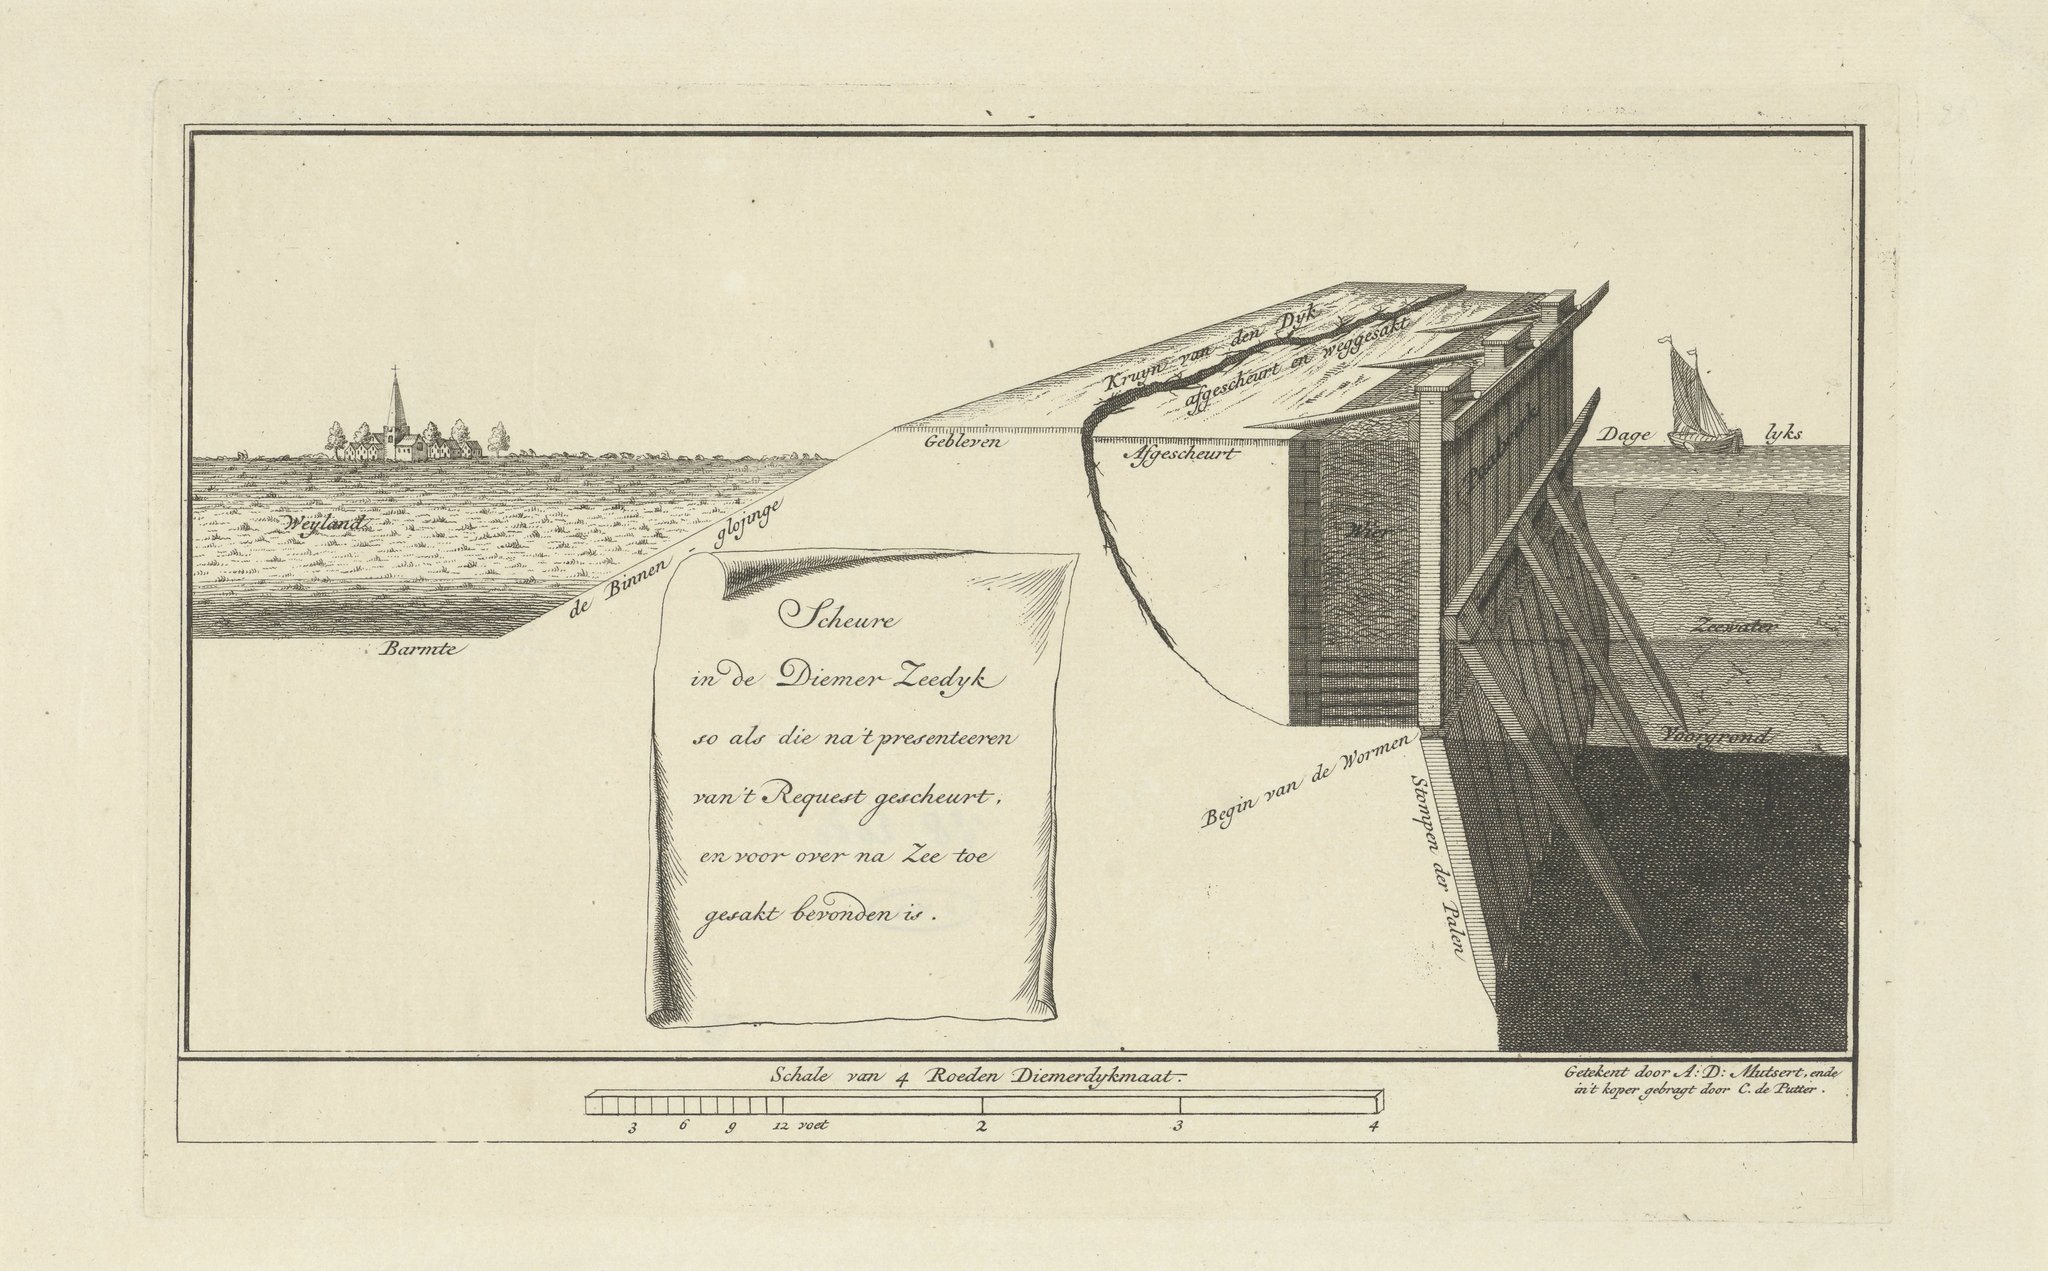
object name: print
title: Profiel van de Diemerzeedijk met scheur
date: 1729-1737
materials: paper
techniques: engraving, etching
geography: amsterdam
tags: dike-break, prospect of village, silhouette of village, sailing-ship, sailing-boat, dikes, levee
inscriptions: collector's mark: Lugt 2228, collector's mark: Lugt 2165, collector's mark: Lugt 2760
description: Rond 1730 waren de houten palen van de Diemerzeedijk ernstig aangetast door paalworm. In 1737 zouden de houten palen worden vervangen door stenen. Landmeter A.D. Mutsert maakte een aantal tekeningen van de toenmalige Diemerzeedijk en Diemerlanddijk en mogelijke verbeteringen, waarvan ook prenten zijn gemaakt. De huidige prent is daar een van. Zie ook RP-P-AO-8-38 en RP-P-AO-8-39.